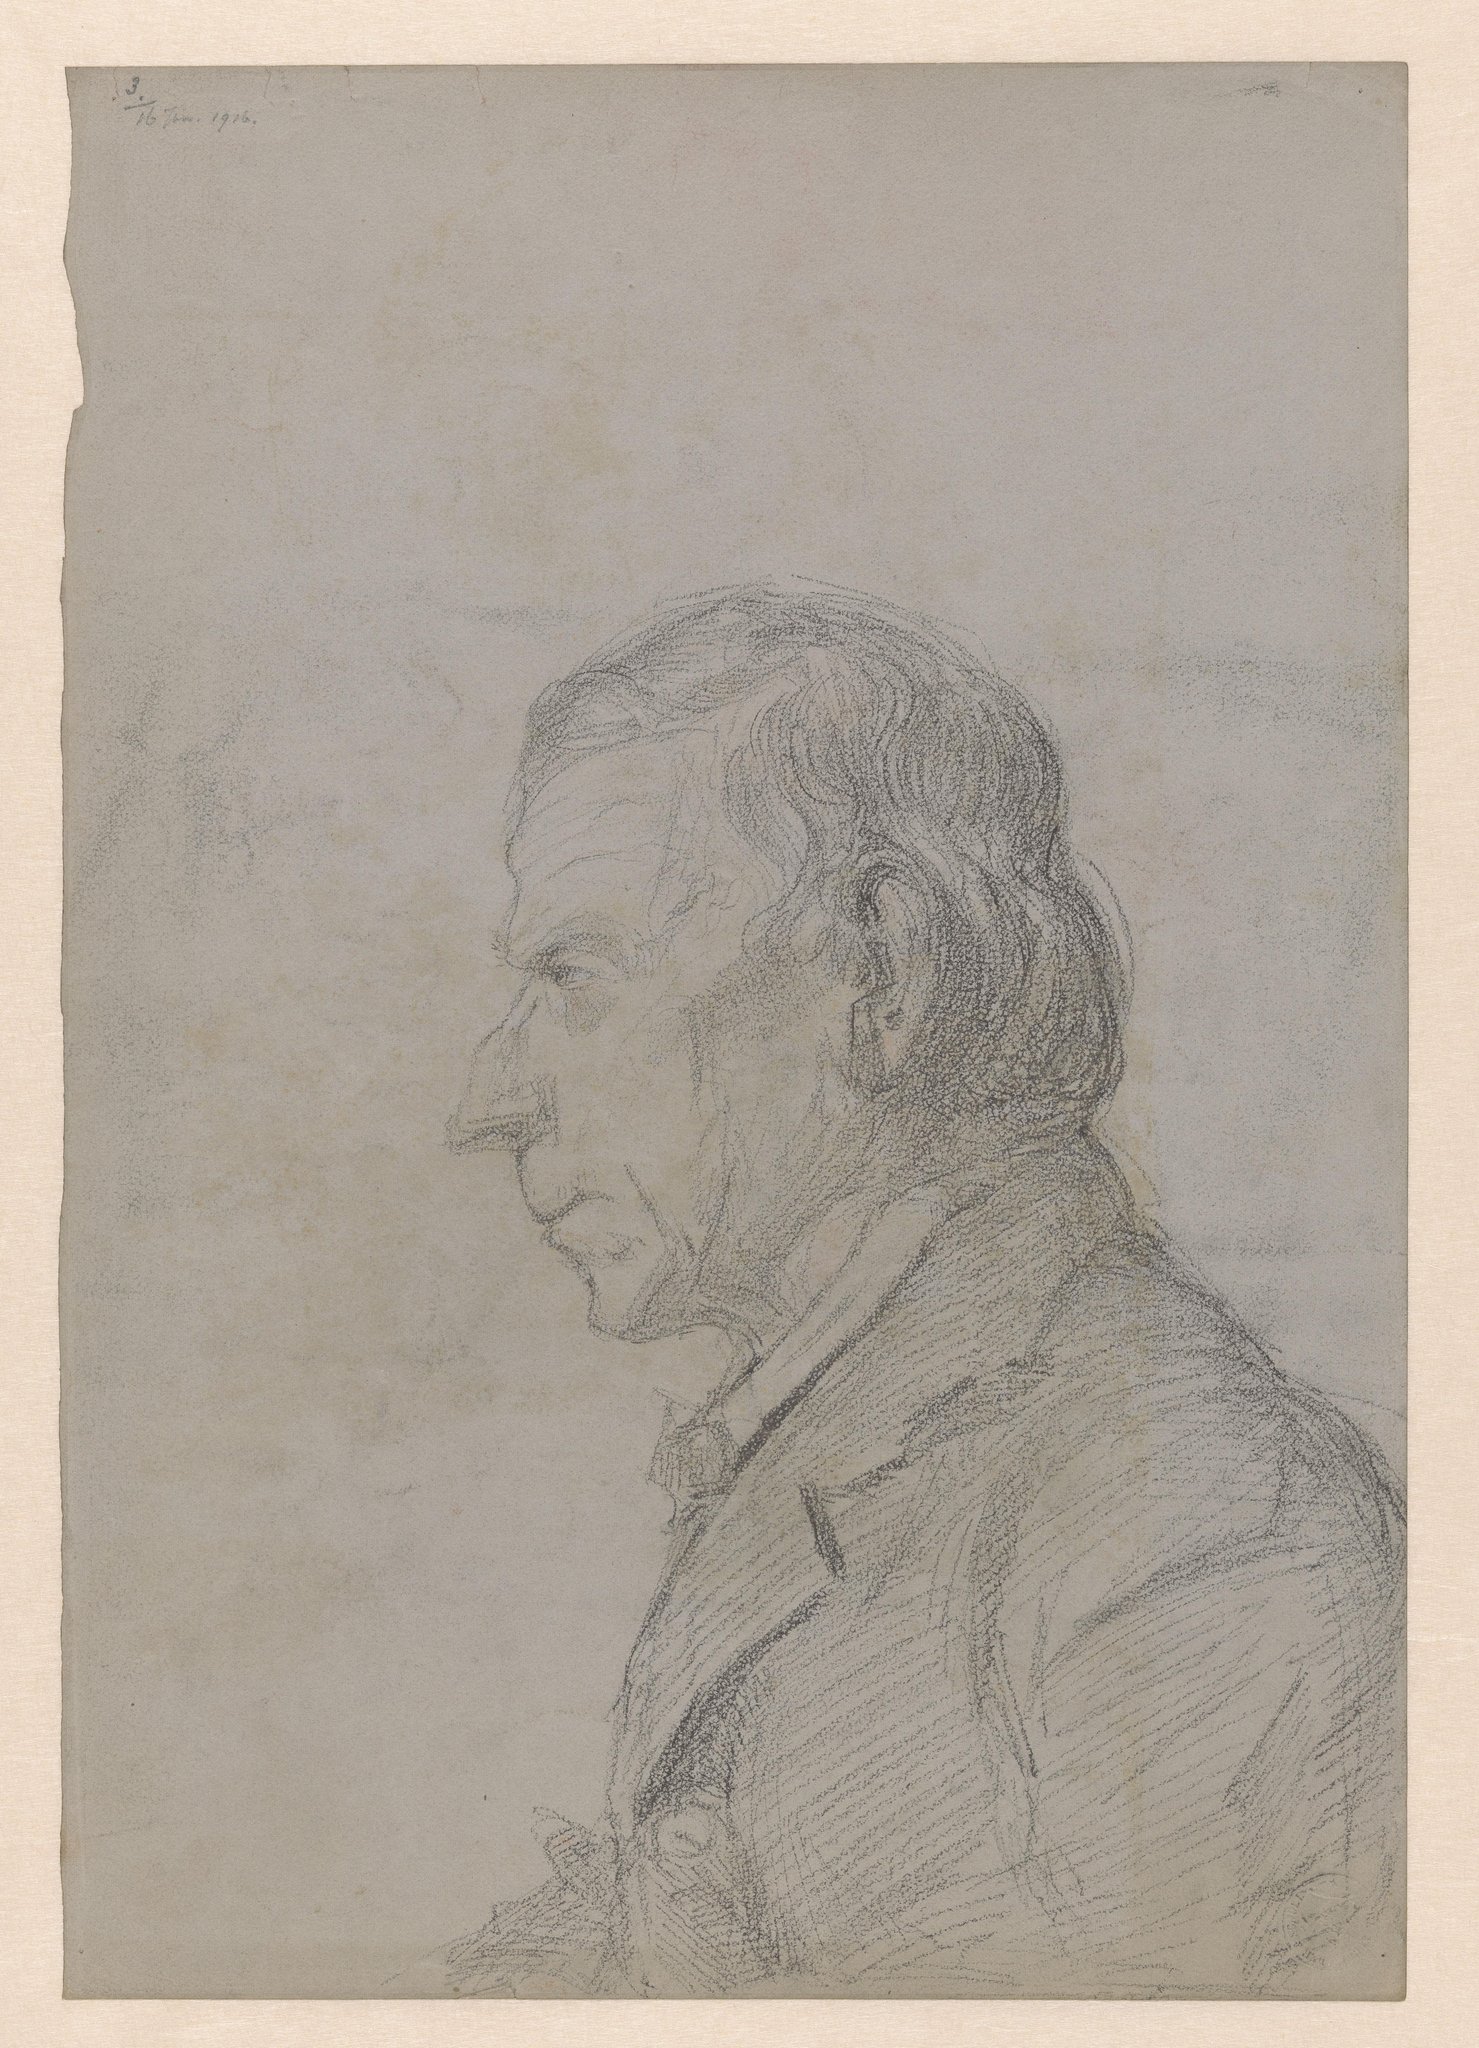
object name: drawing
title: Portret van een onbekende man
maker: jan paul valkema blouw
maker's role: draughtsman, print maker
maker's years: 1884-1954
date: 1916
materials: chalk, paper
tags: anonymous historical person portrayed alone, male sex; man